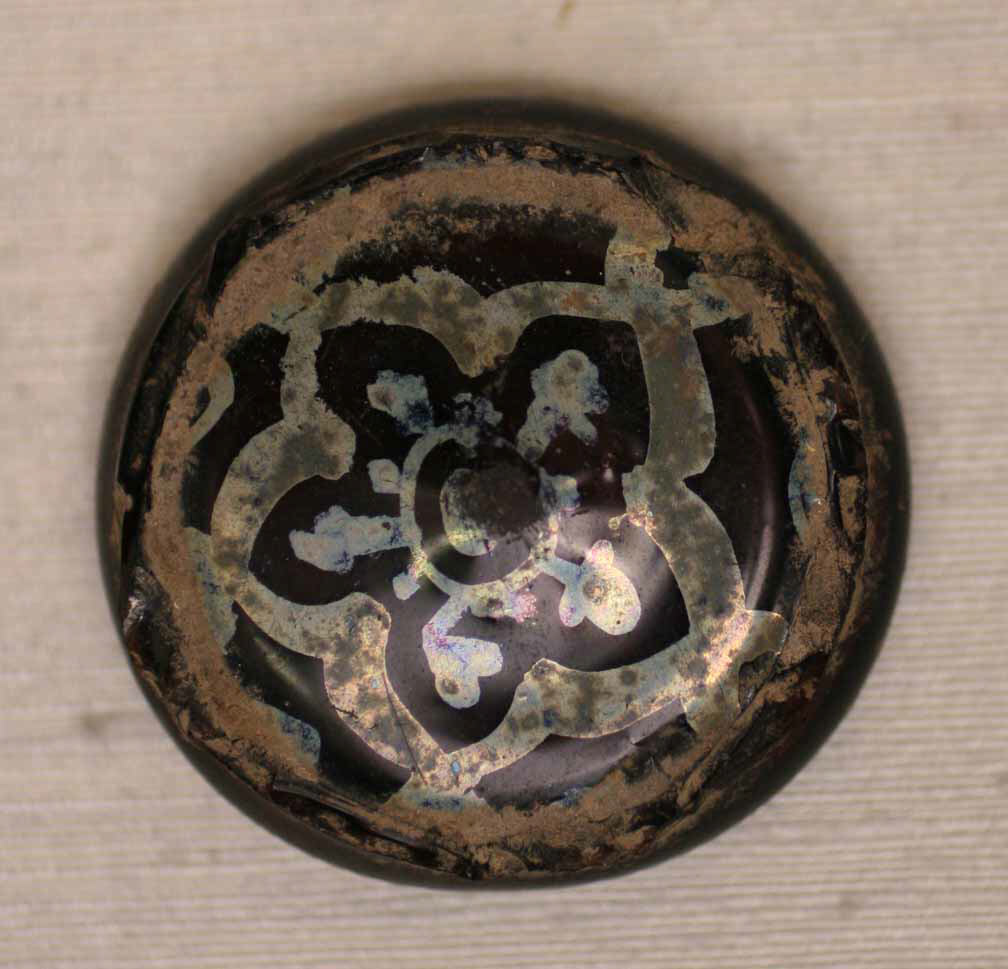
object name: fragment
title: Glass Fragment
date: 901-1100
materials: glass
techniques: luster painting, stain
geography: egypt